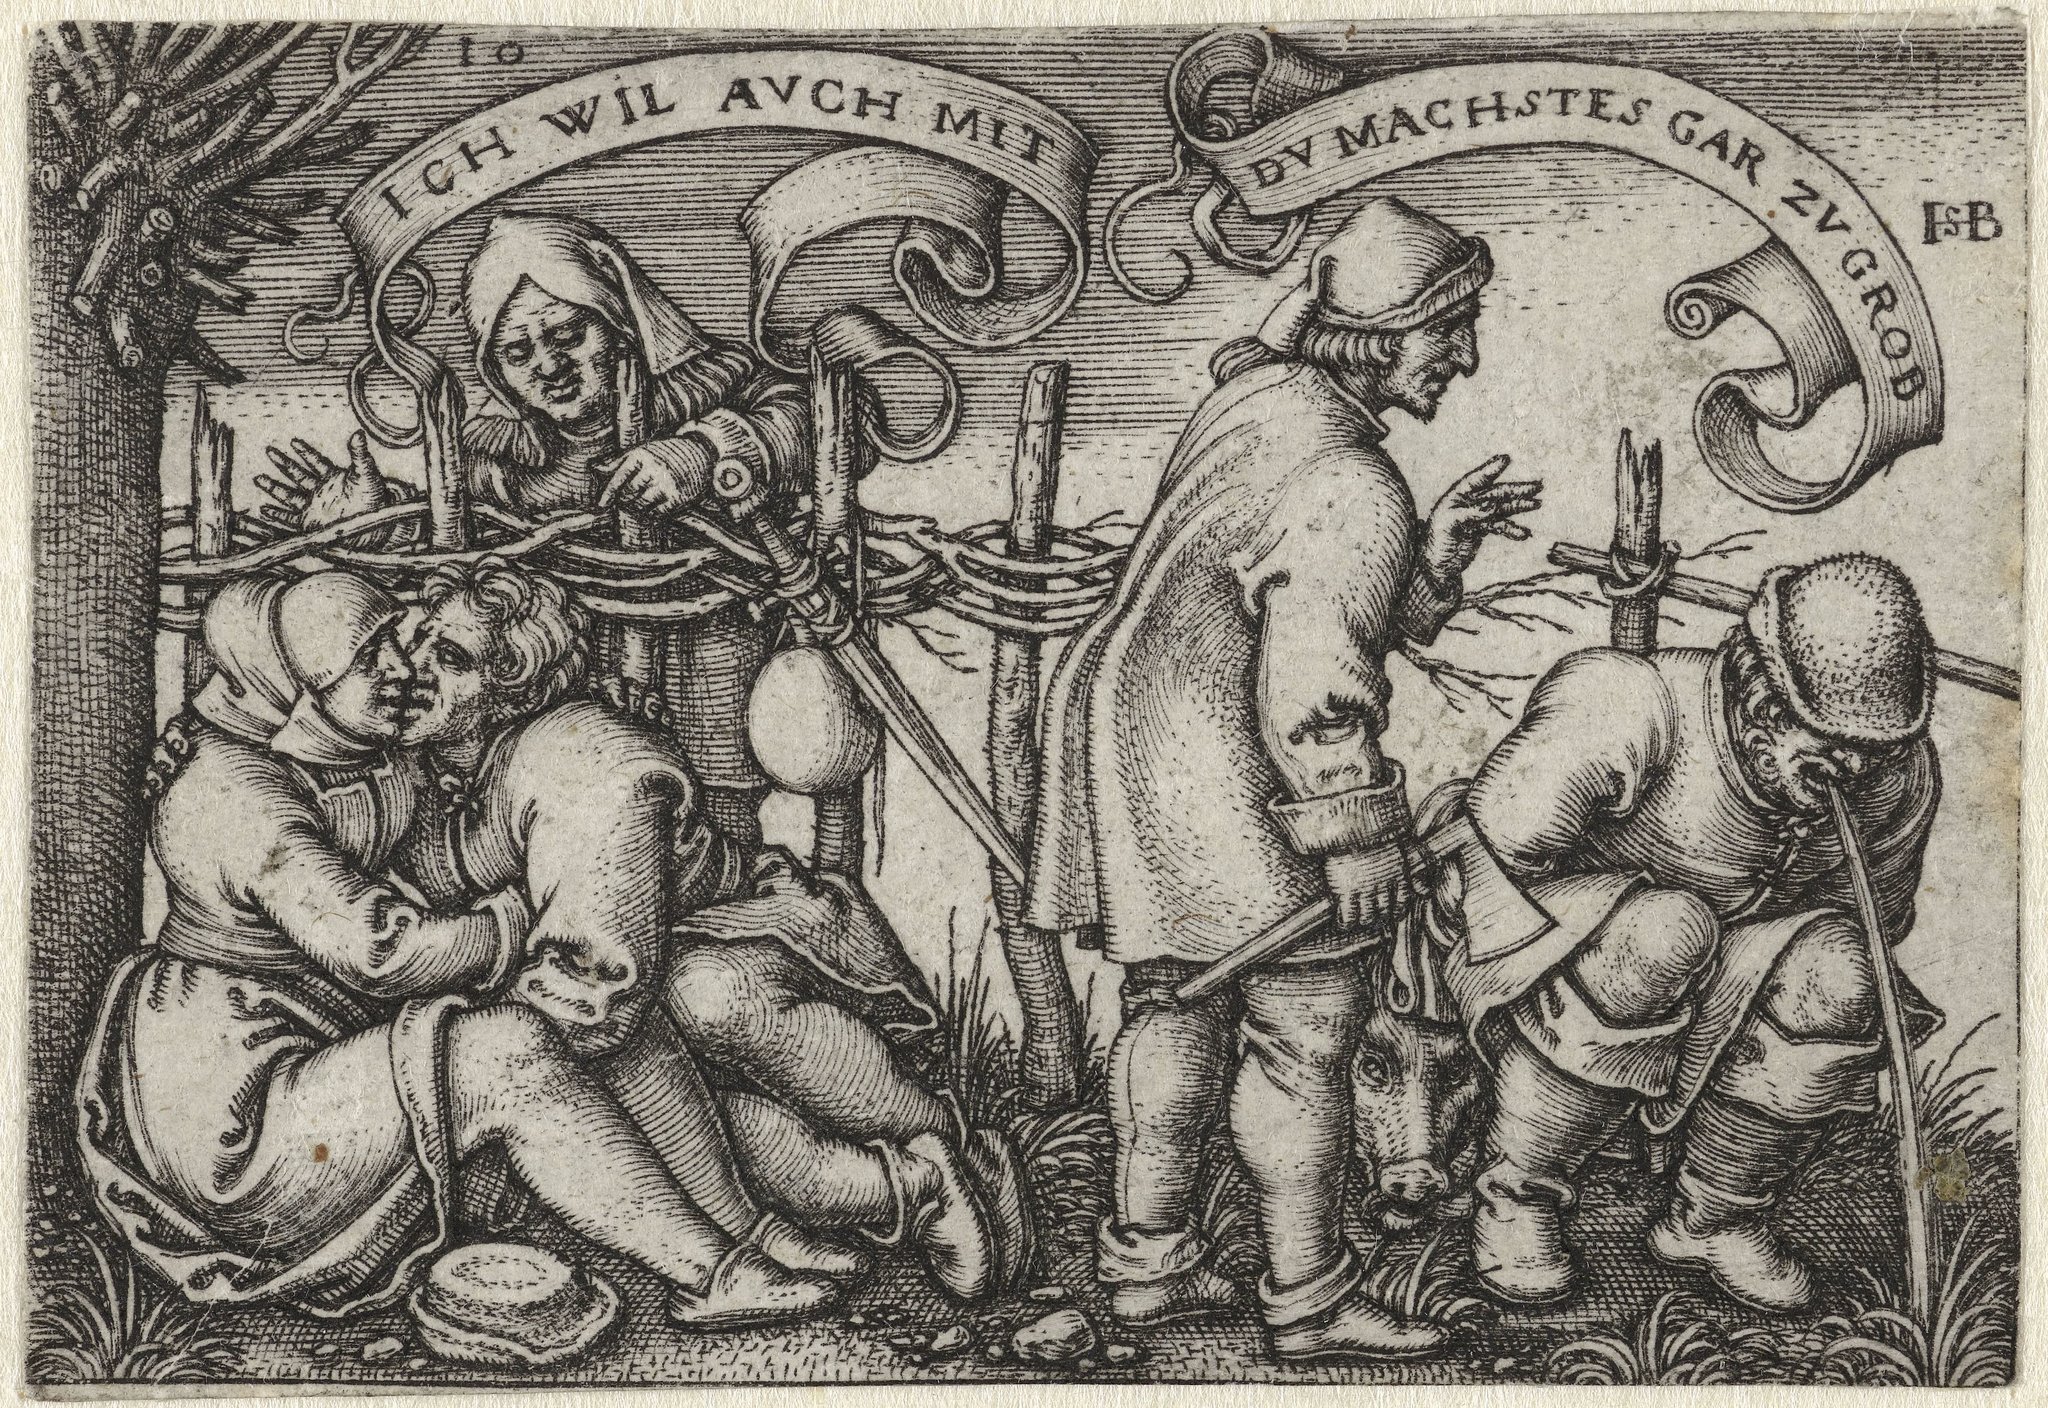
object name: print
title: Ich wil avch mit - Dv machtes gar zv gross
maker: hans sebald beham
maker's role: designer, draughtsman, print maker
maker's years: 1500-1550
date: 1546-1547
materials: paper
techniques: engraving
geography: frankfurt am main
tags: vomiting, embracing each other, kissing, farmers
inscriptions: collector's mark: Lugt 2228a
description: De voorstellingen in deze reeks prenten zijn gebaseerd op een andere serie met het thema Boerenfeest welke bijna tien jaar eerder werd vervaardigd. Hier worden twee scènes op een prent gecombineerd, het vrijende paar dat wordt begluurd is in spiegelbeeld weergegeven.